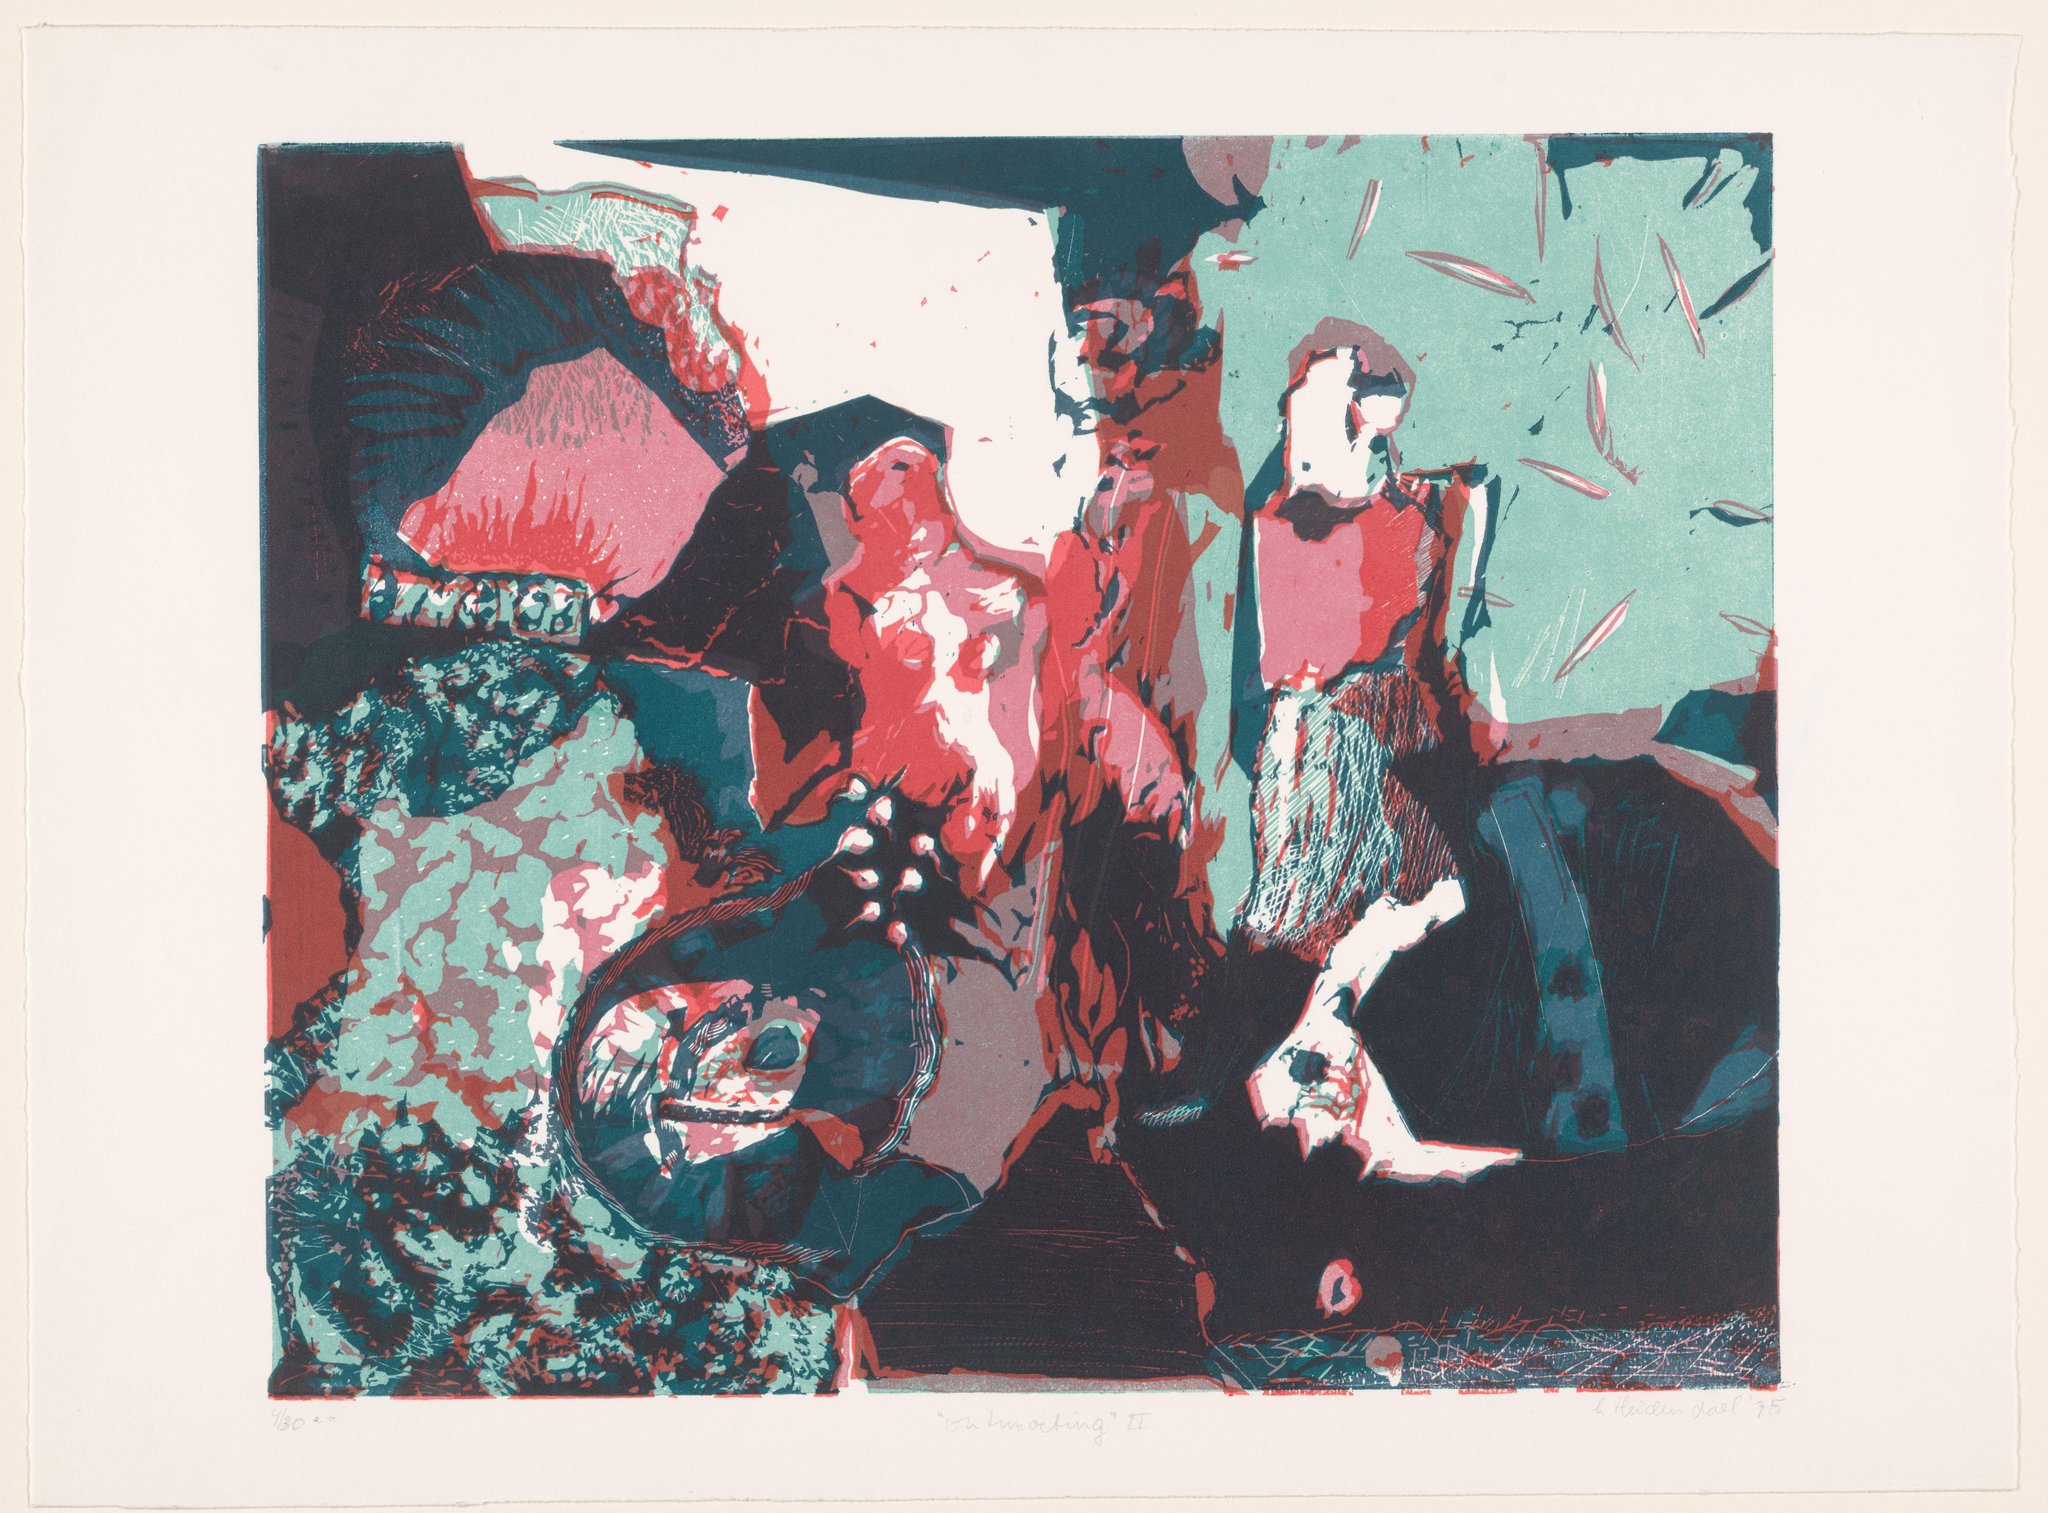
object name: print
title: Ontmoeting II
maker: lau heidendael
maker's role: print maker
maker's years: 1946-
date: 1975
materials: paper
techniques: linocut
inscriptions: signature and date: ‘L Heidendael '75’, title: ‘"ontmoeting " II’, edition: ‘4/30 e a’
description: Veelkleurige voorstelling met twee figuren en links zaad.